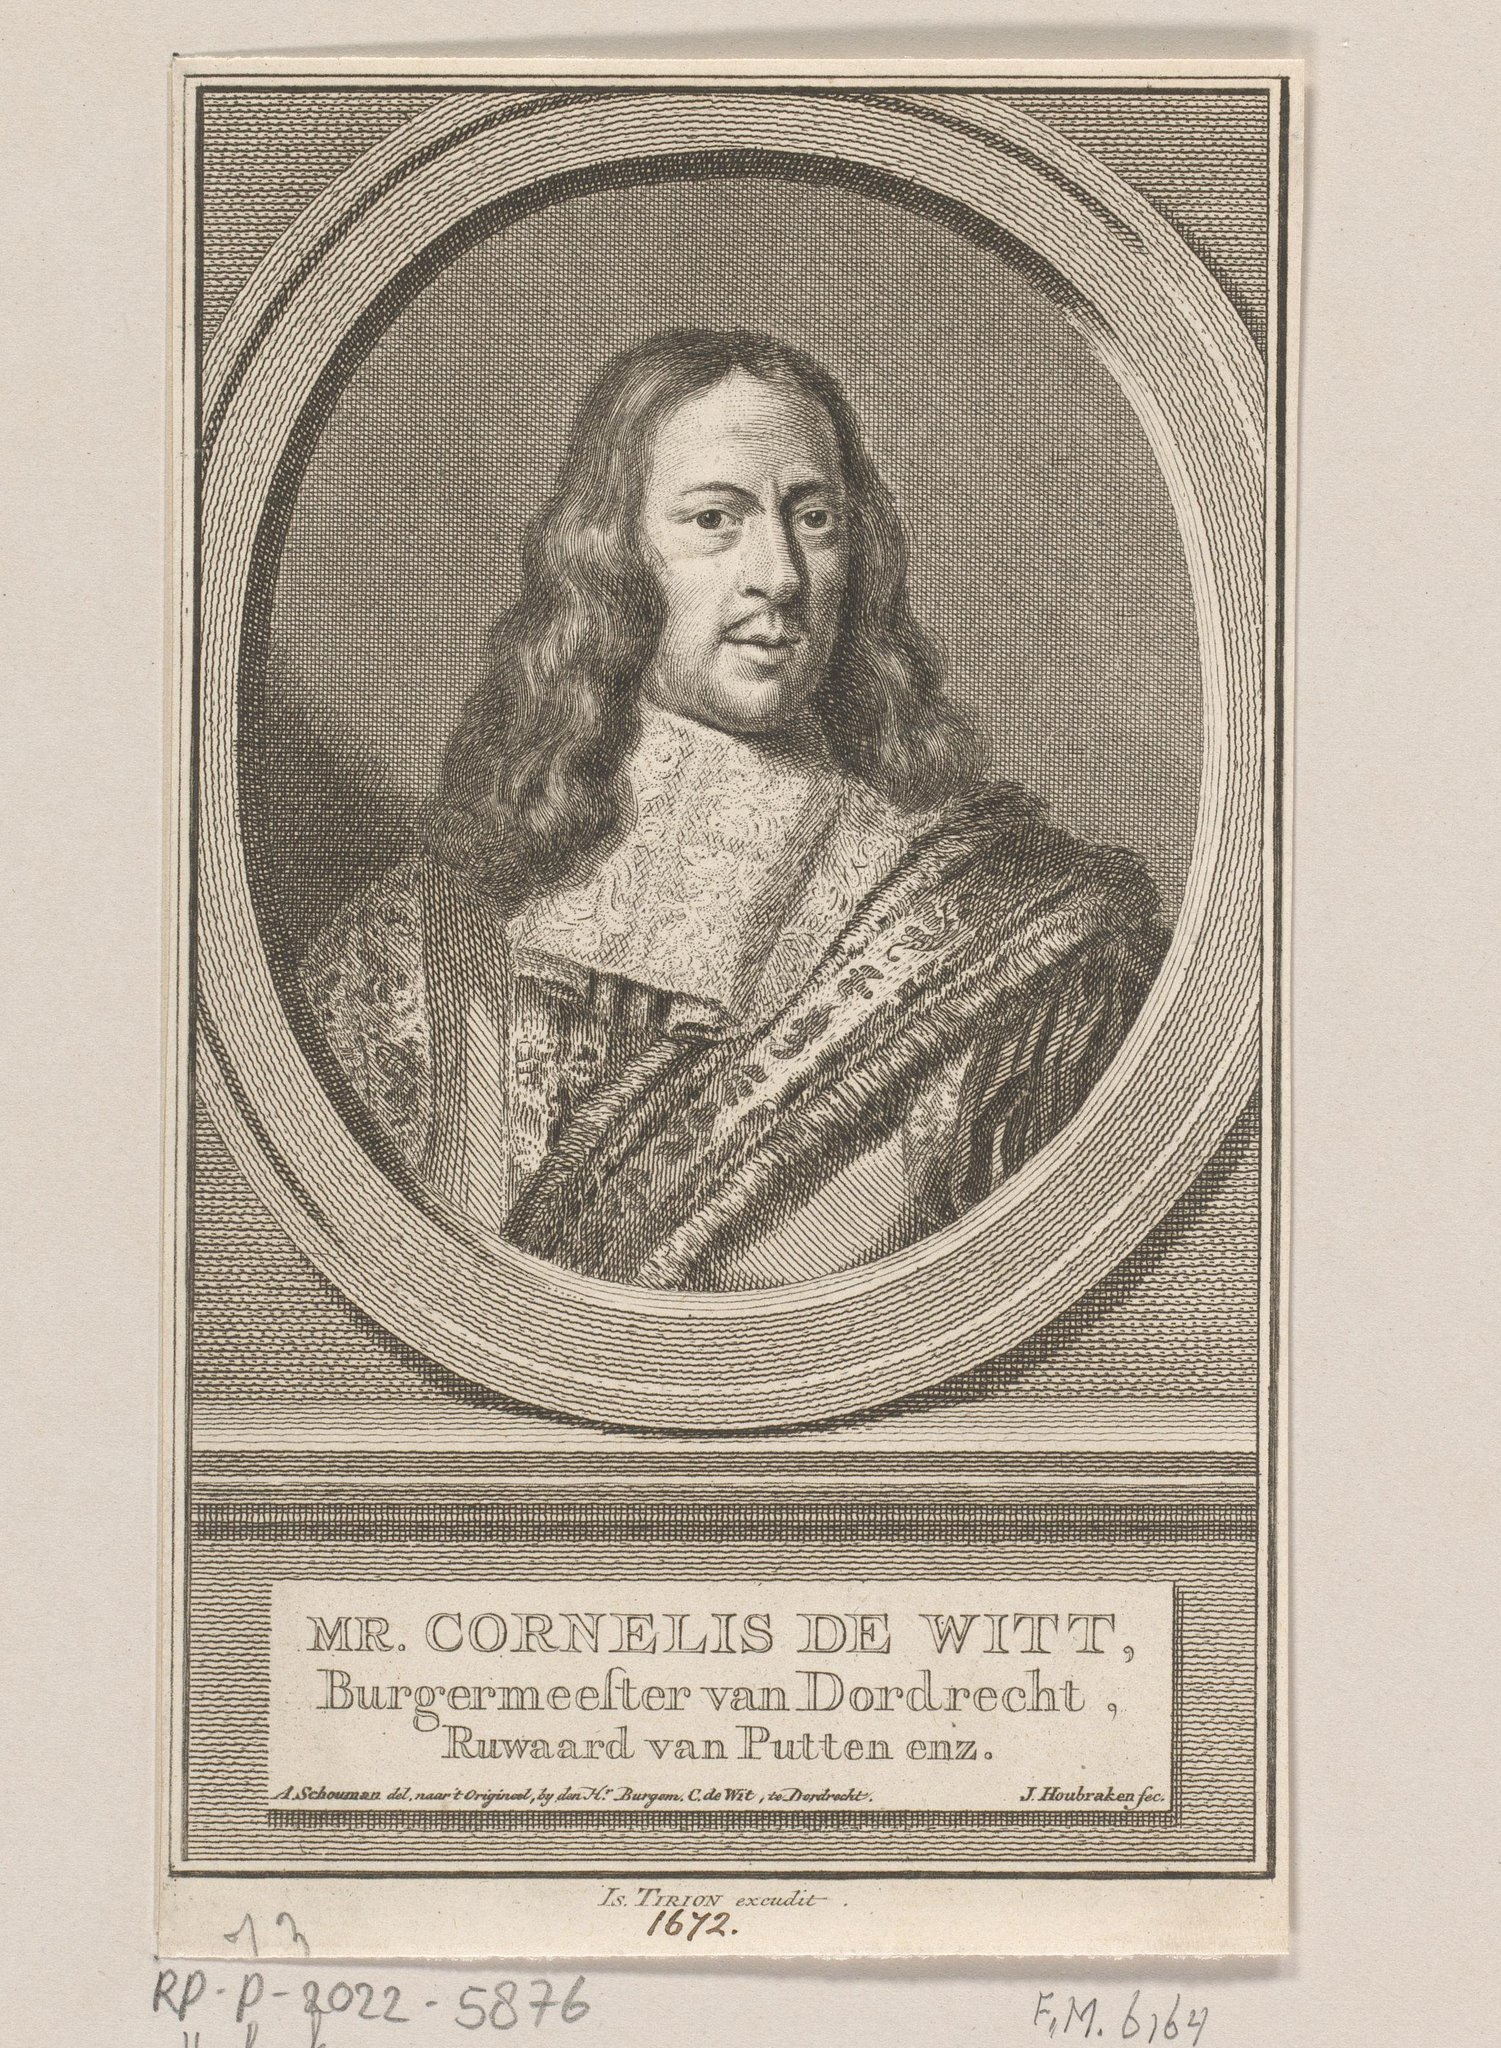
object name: book illustration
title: Portret van Cornelis de Witt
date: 1749-1759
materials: paper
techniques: engraving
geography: amsterdam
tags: dordrecht, the hague, cornelis de witt, historical persons, governor, etc. of province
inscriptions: number: ‘1672’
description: Prent waarschijnlijk uit: Wagenaar, Jan. Vaderlandsche historie, vervattende de geschiedenissen der Vereenigde Nederlanden (…). 21 delen. Amsterdam: Isaak Tirion, 1756, dl. 14. Prent mogelijk ook gebruikt in latere edities van dit werk.